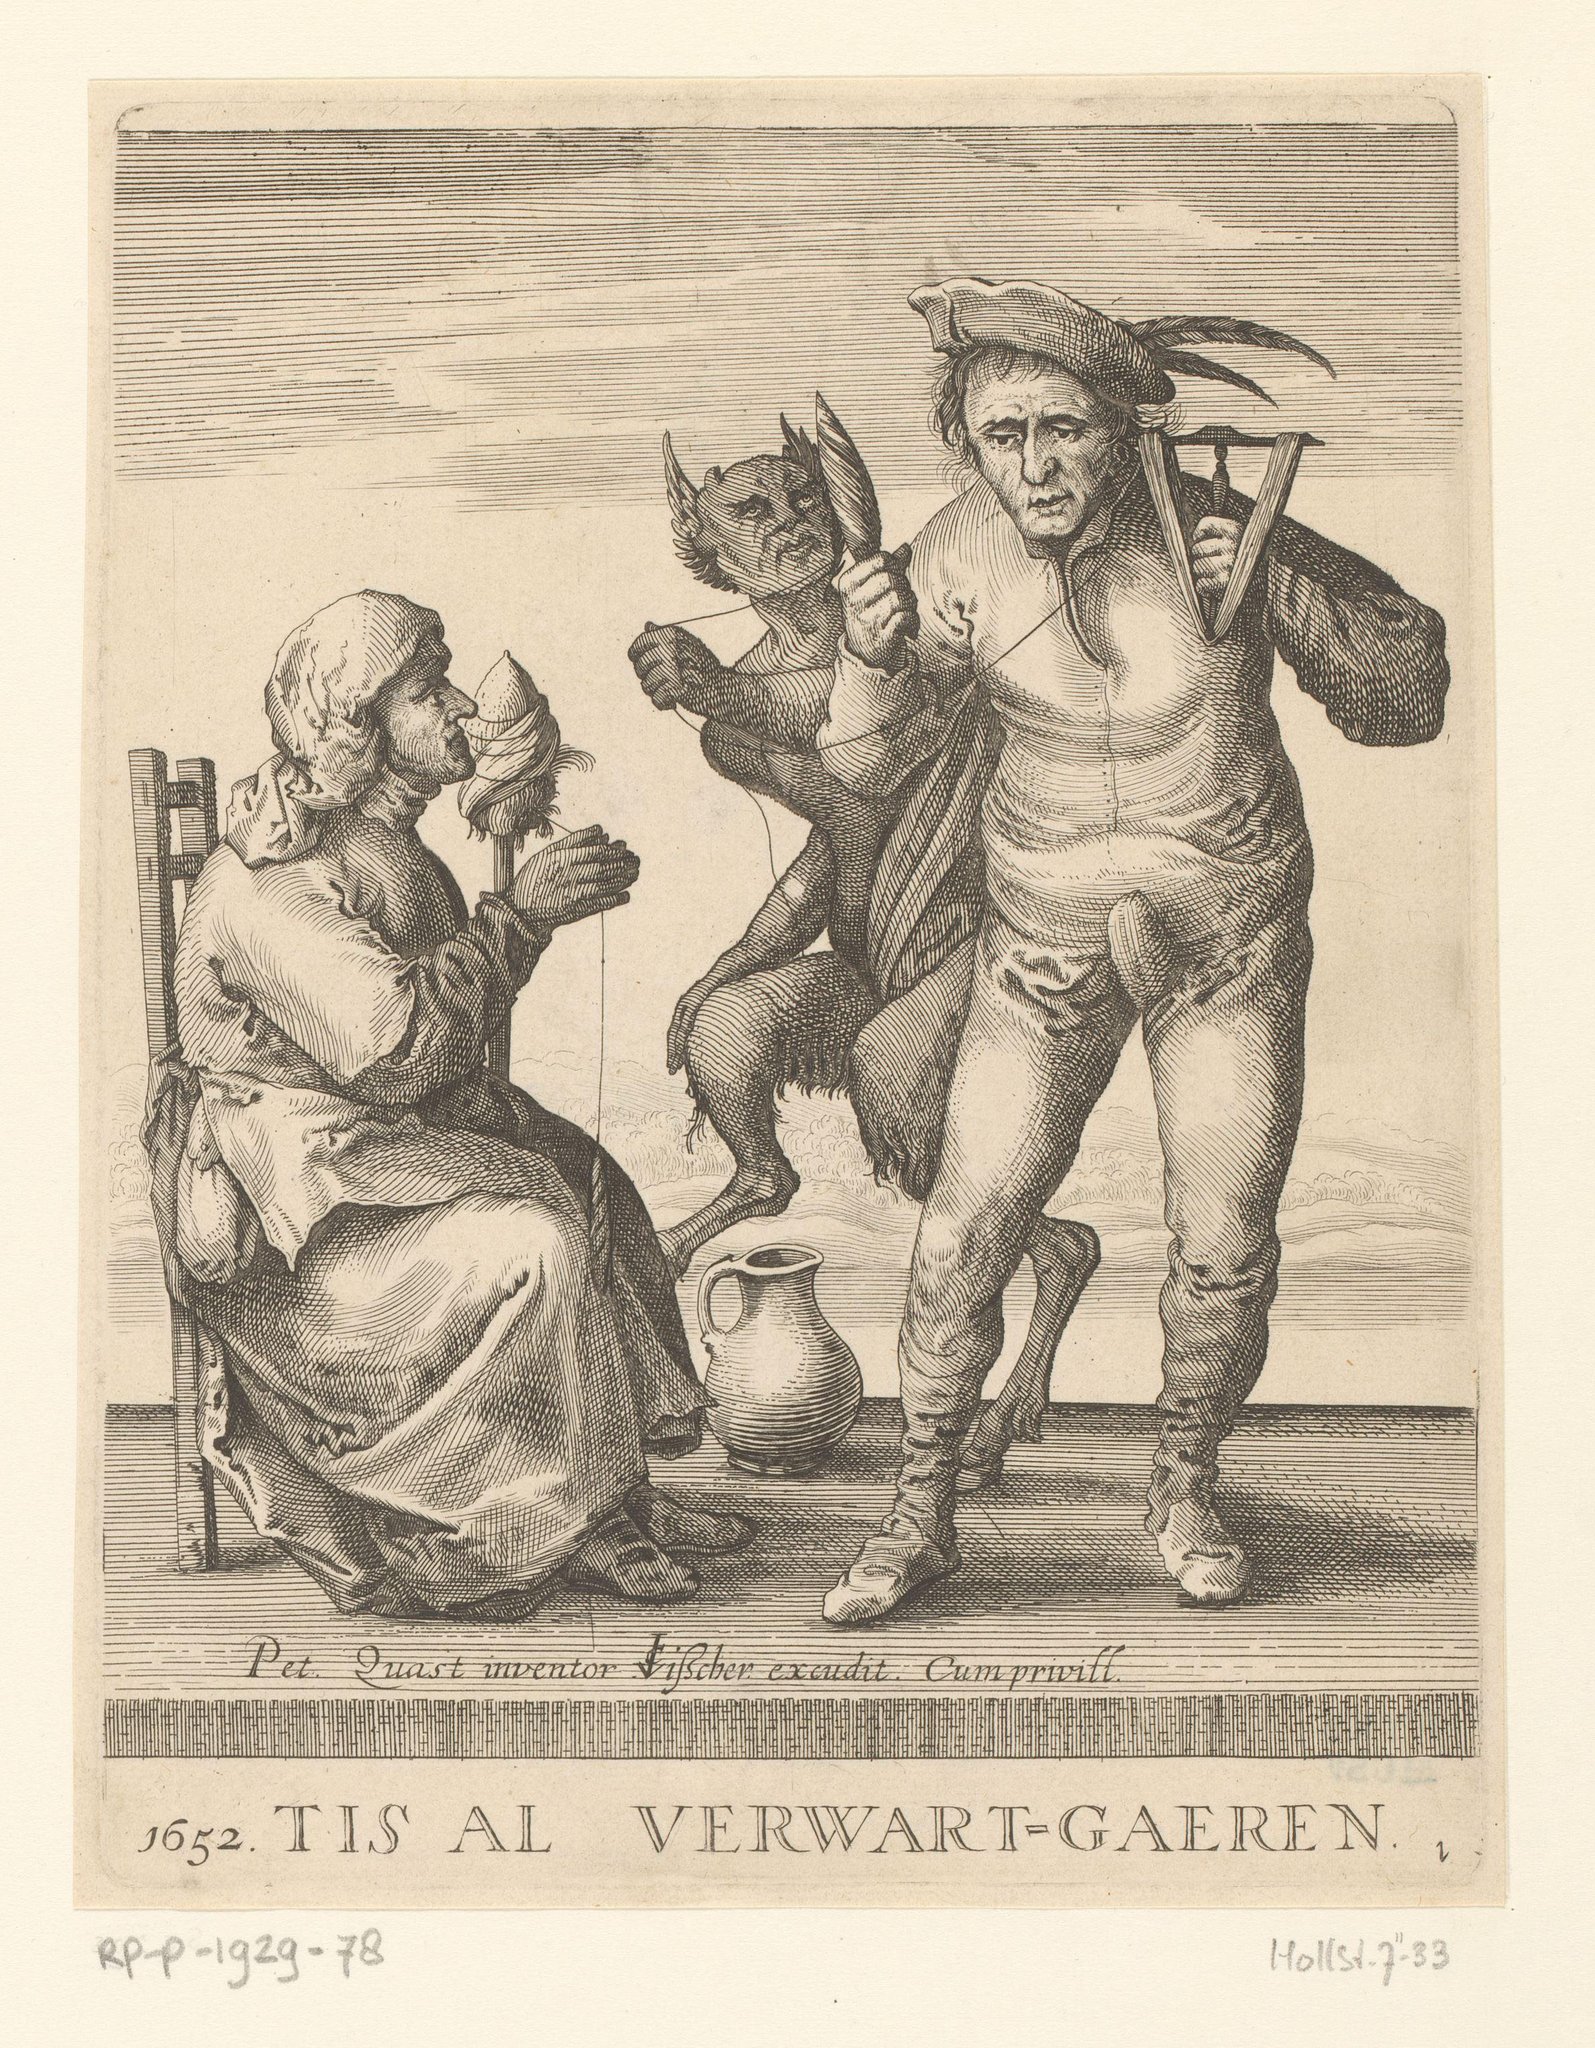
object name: print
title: Duivel verwart het garen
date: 1638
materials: paper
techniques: engraving, etching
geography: amsterdam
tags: devils in the form of (fabulous) animals, spinning (manufacture of yarn)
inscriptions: collector's mark: Lugt 2165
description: Door Muller opgenomen als mogelijk een spotprent of allegorie op de Engelsen tijdens de Eerste Engelse Oorlog vanwege het jaartal 1652 en het gebruik van een kopie naar deze voorstelling door Salomon Savery in een politieke context (zie FMH 2046A, bijvoorbeeld RP-P-OB-5562). De eerste staat van deze prent werd in 1638 door Hondius uitgegeven.